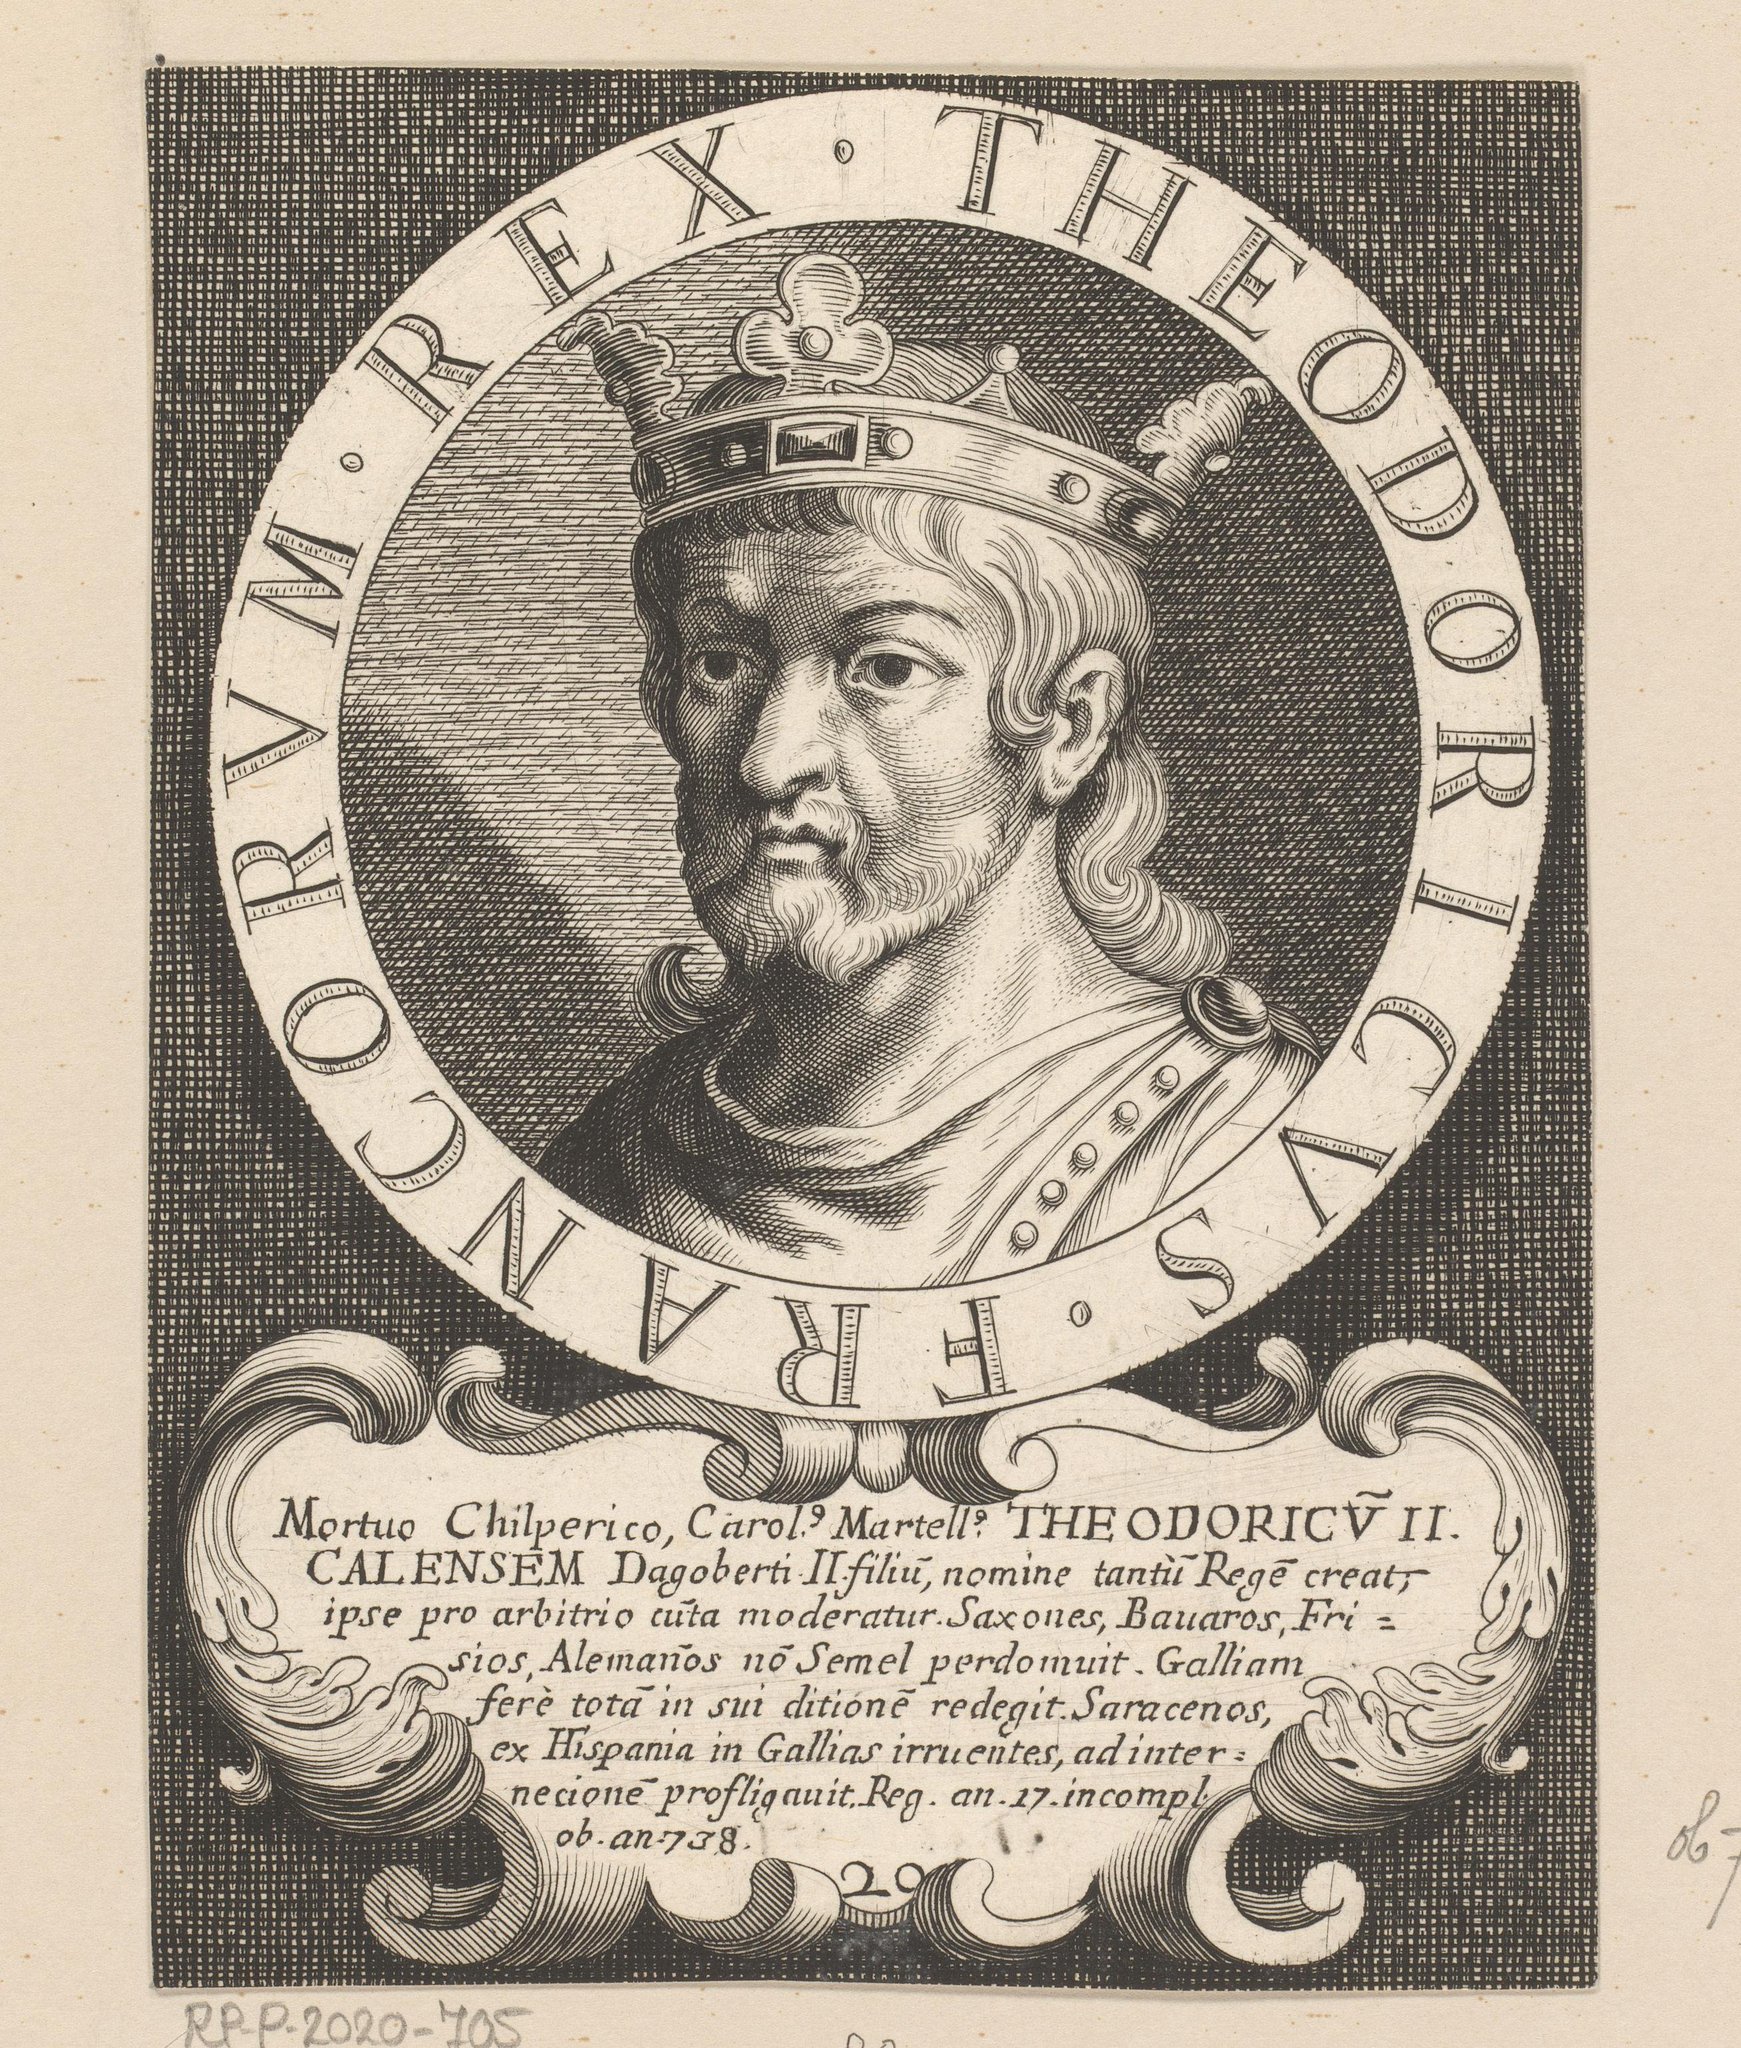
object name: print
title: Theodoricus Francorum Rex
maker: Anonymous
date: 1630-1699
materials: paper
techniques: engraving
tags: historical persons, ruler, sovereign